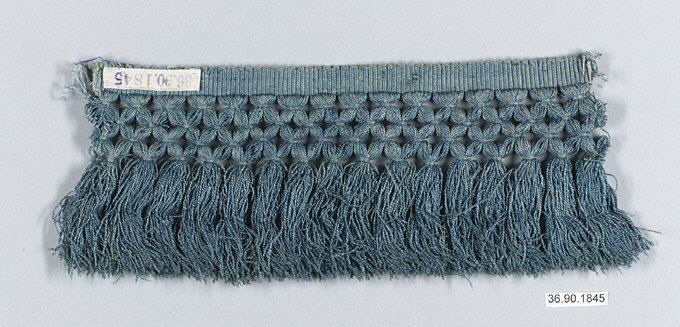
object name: fringe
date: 1801-1833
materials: silk